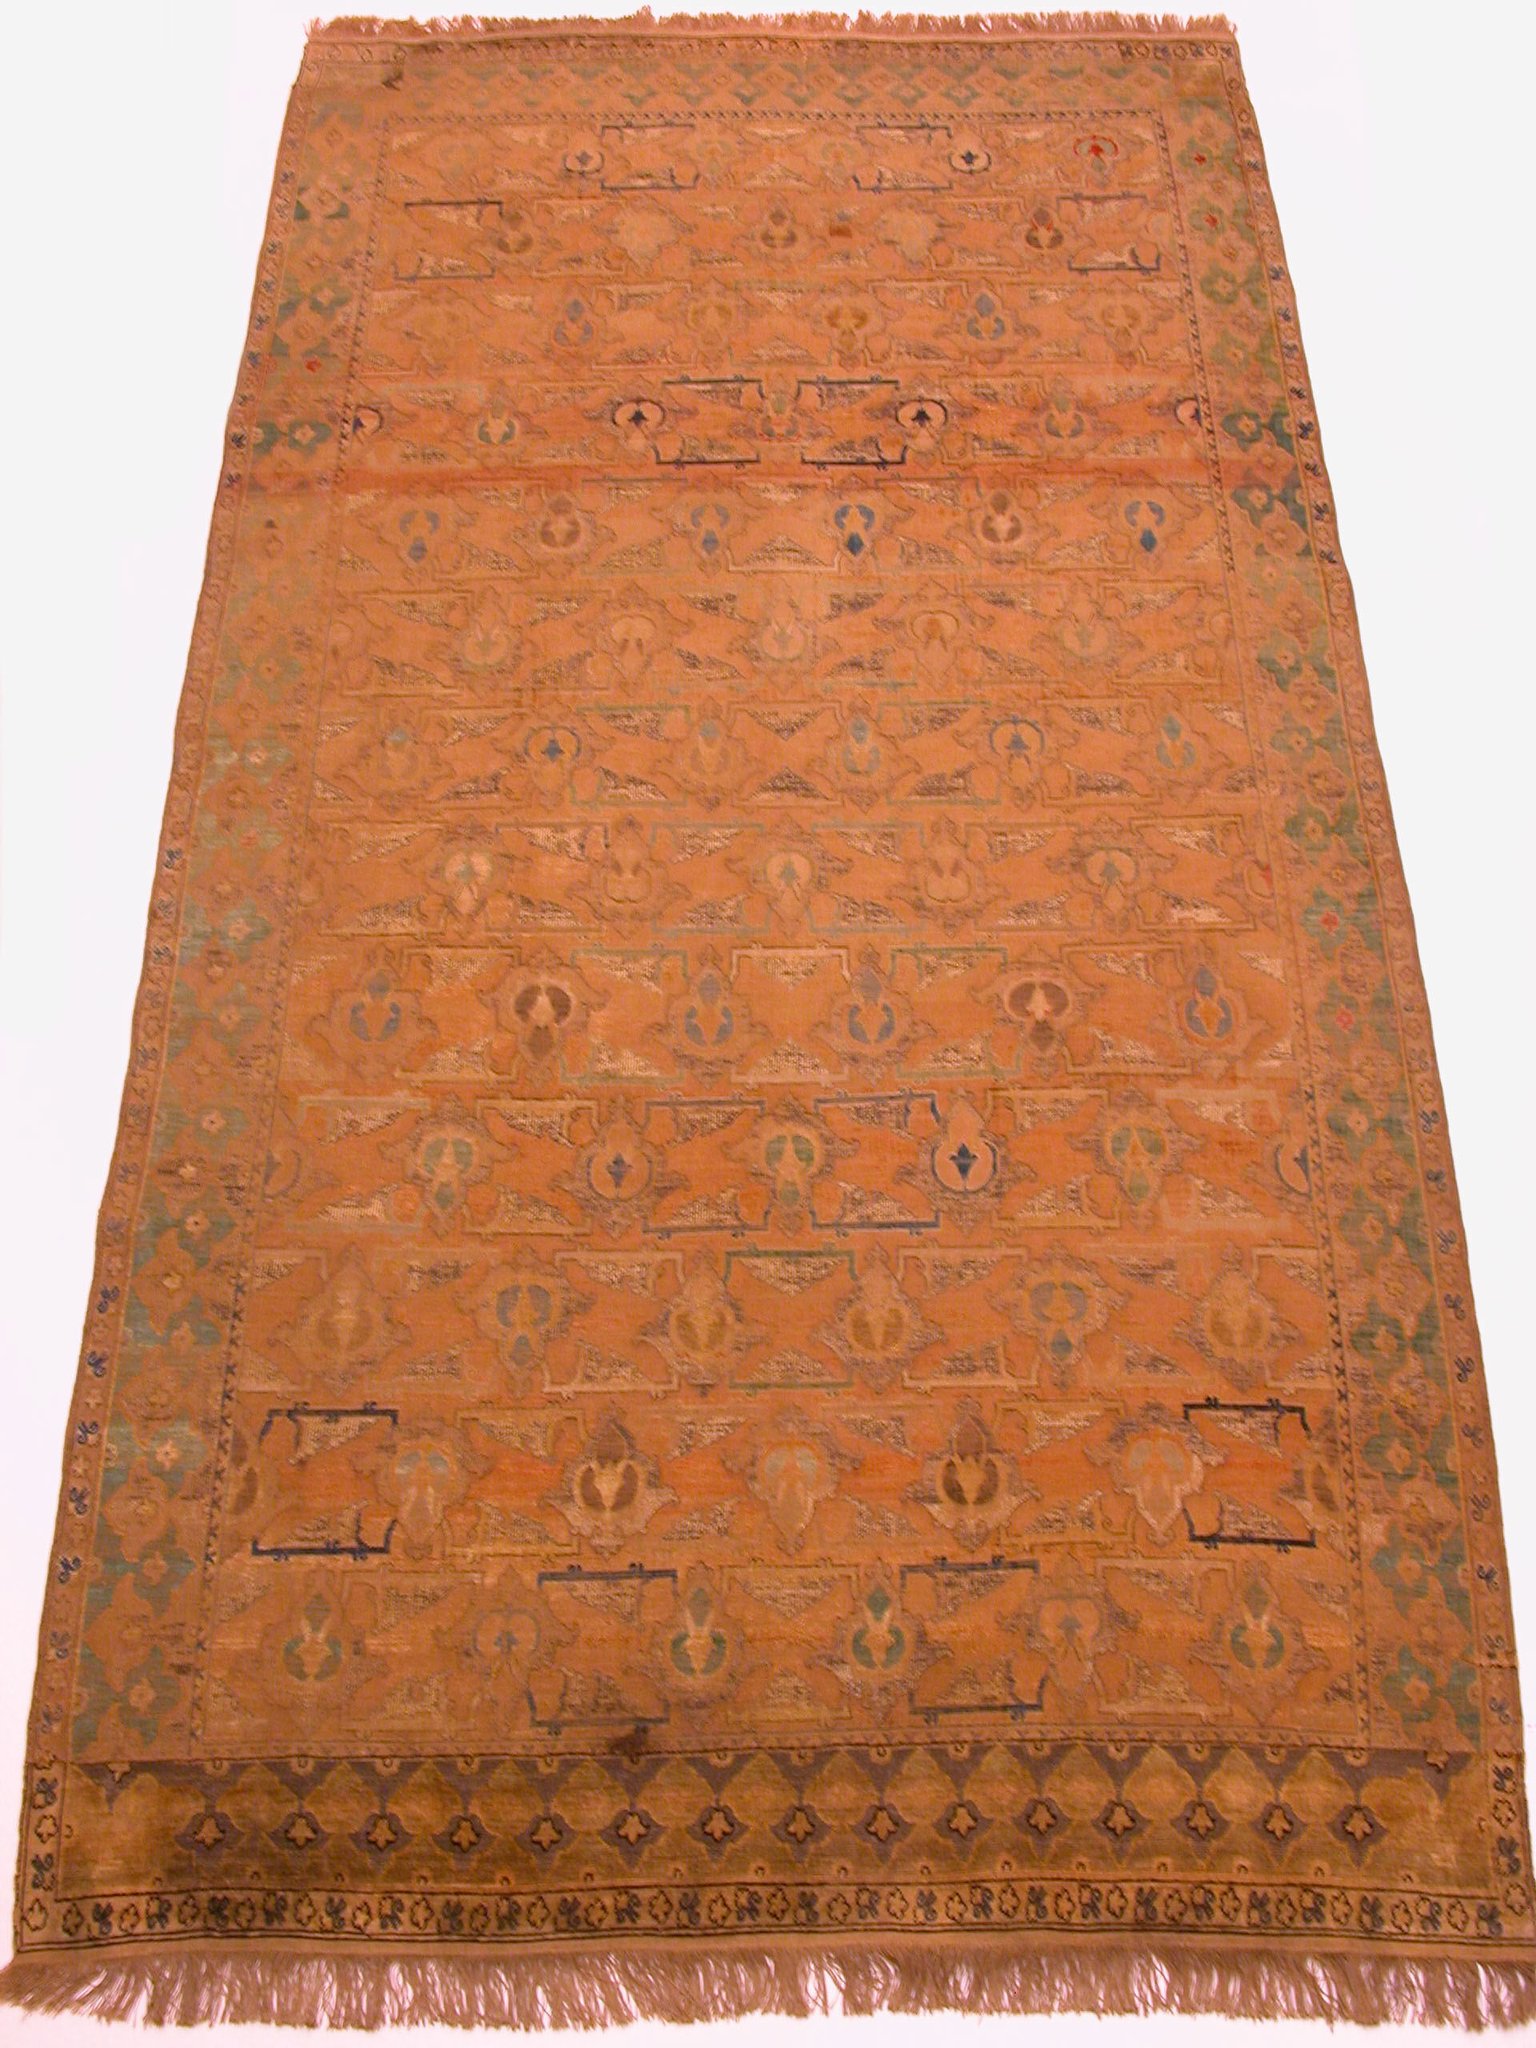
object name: carpet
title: Polonaise Carpet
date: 1601-1700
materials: cotton, metal thread, silk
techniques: asymmetrically knotted pile, brocade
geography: iran